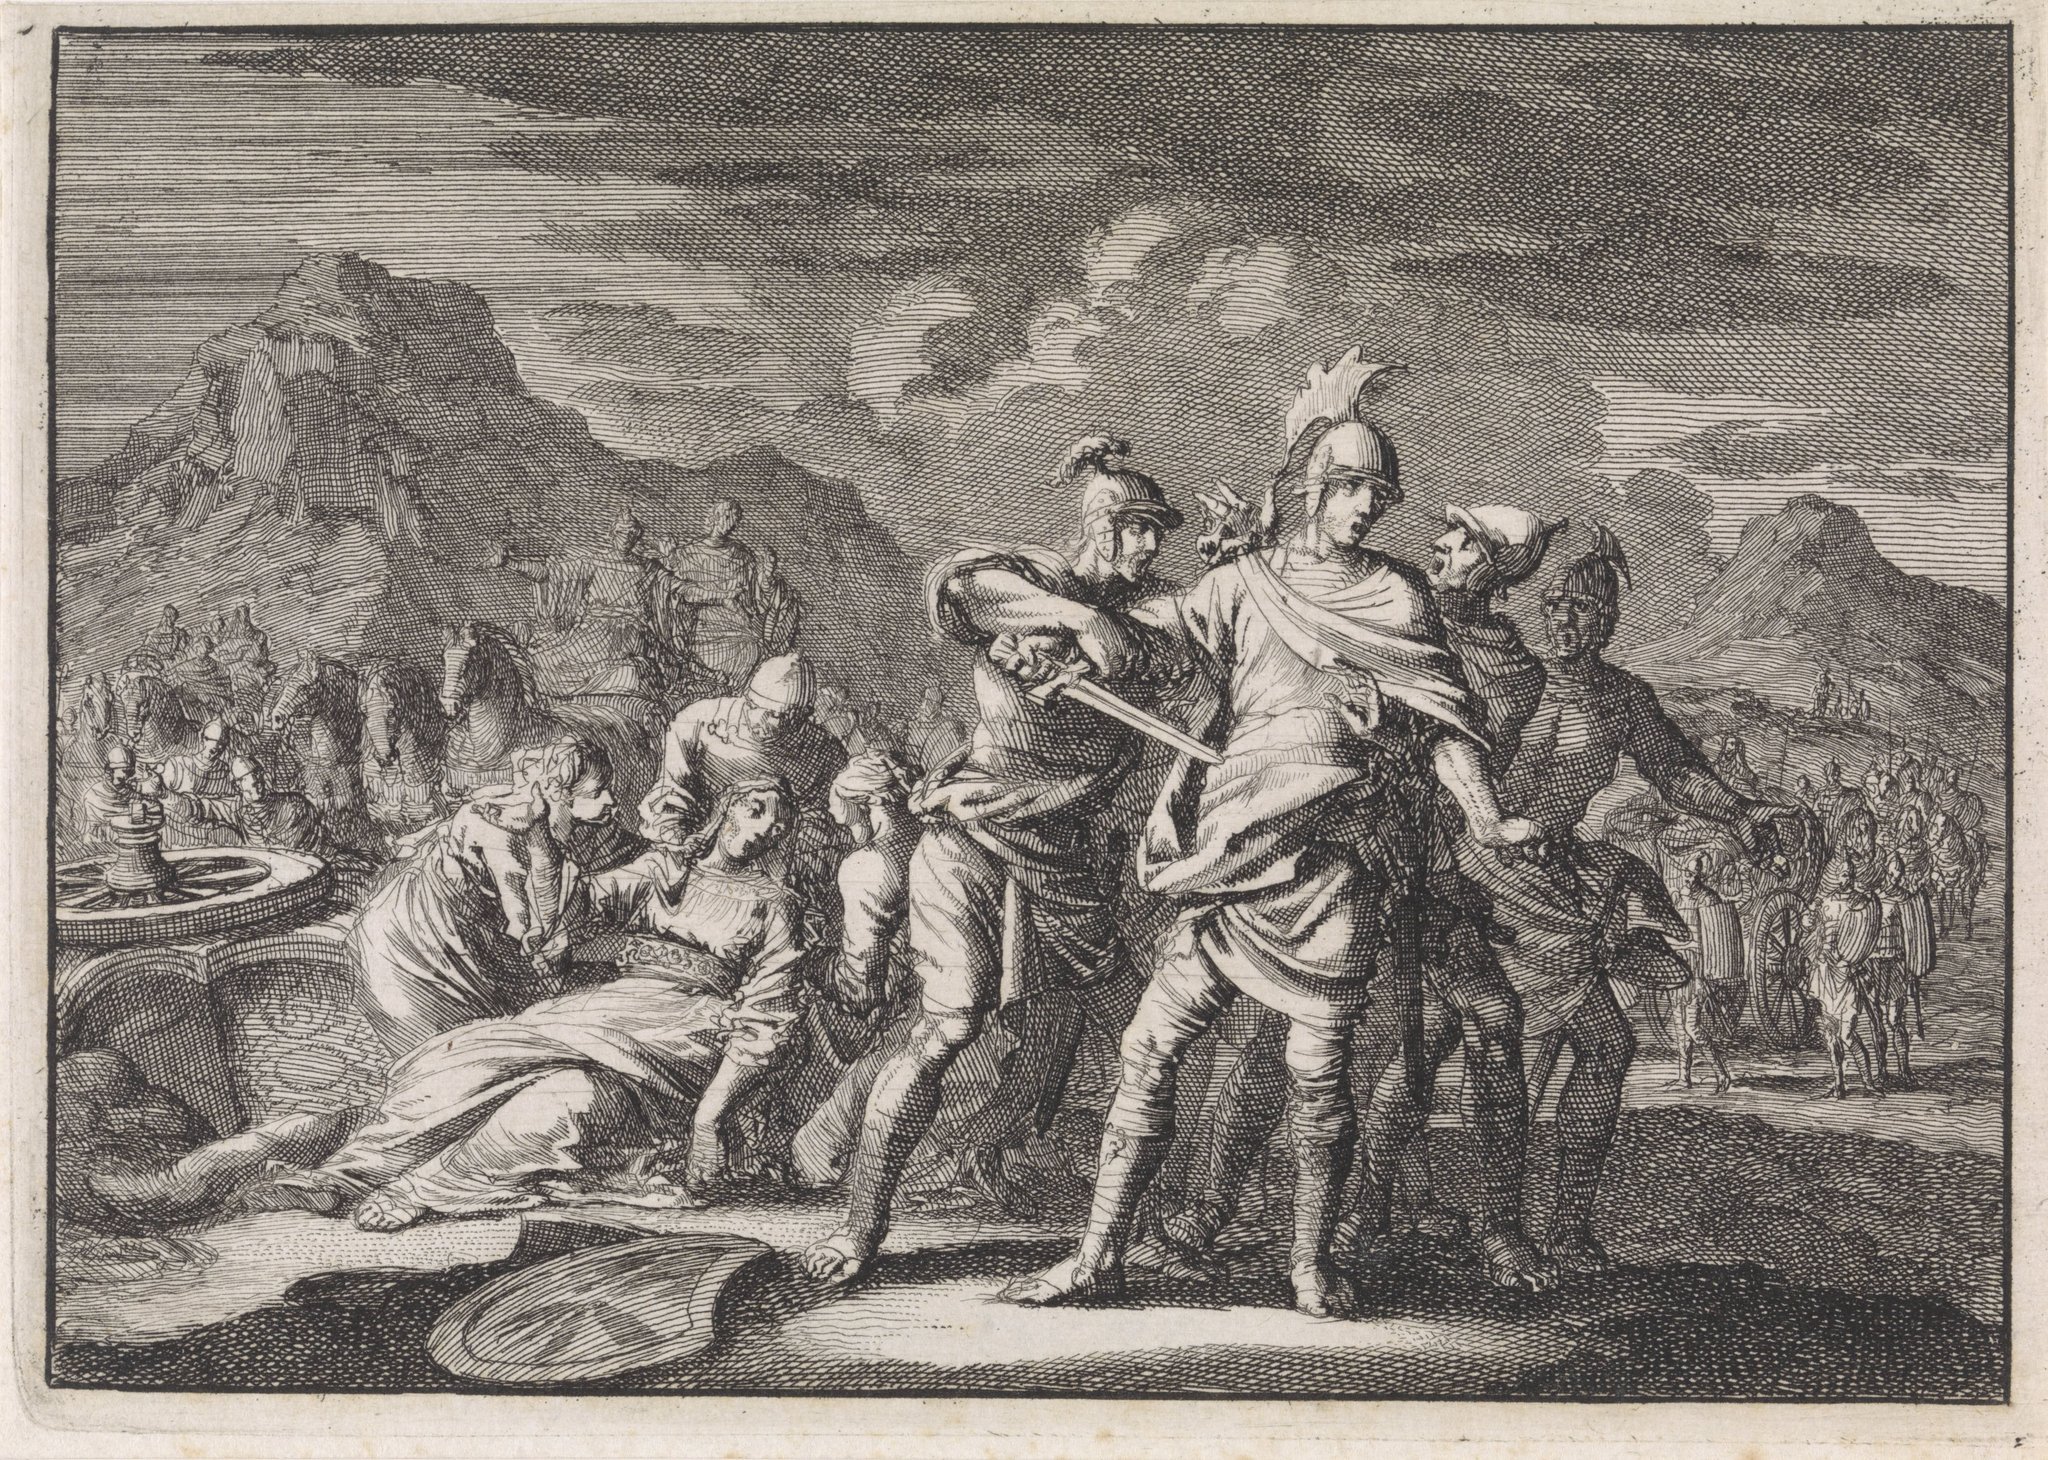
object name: print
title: Herodes wordt door zijn volgers ervan weerhouden zichzelf te doden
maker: jan luyken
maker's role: draughtsman, print maker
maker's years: 1649-1712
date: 1704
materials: paper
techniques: etching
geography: amsterdam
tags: seeking death, suicide - ee - death not certain; wounded person (+ variant)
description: Prent ook gebruikt als boekillustratie in: Josephus, Flavius. Alle de Werken, 2 delen. Amsterdam: Pieter Mortier, 1704, dl. 1, p. 351.